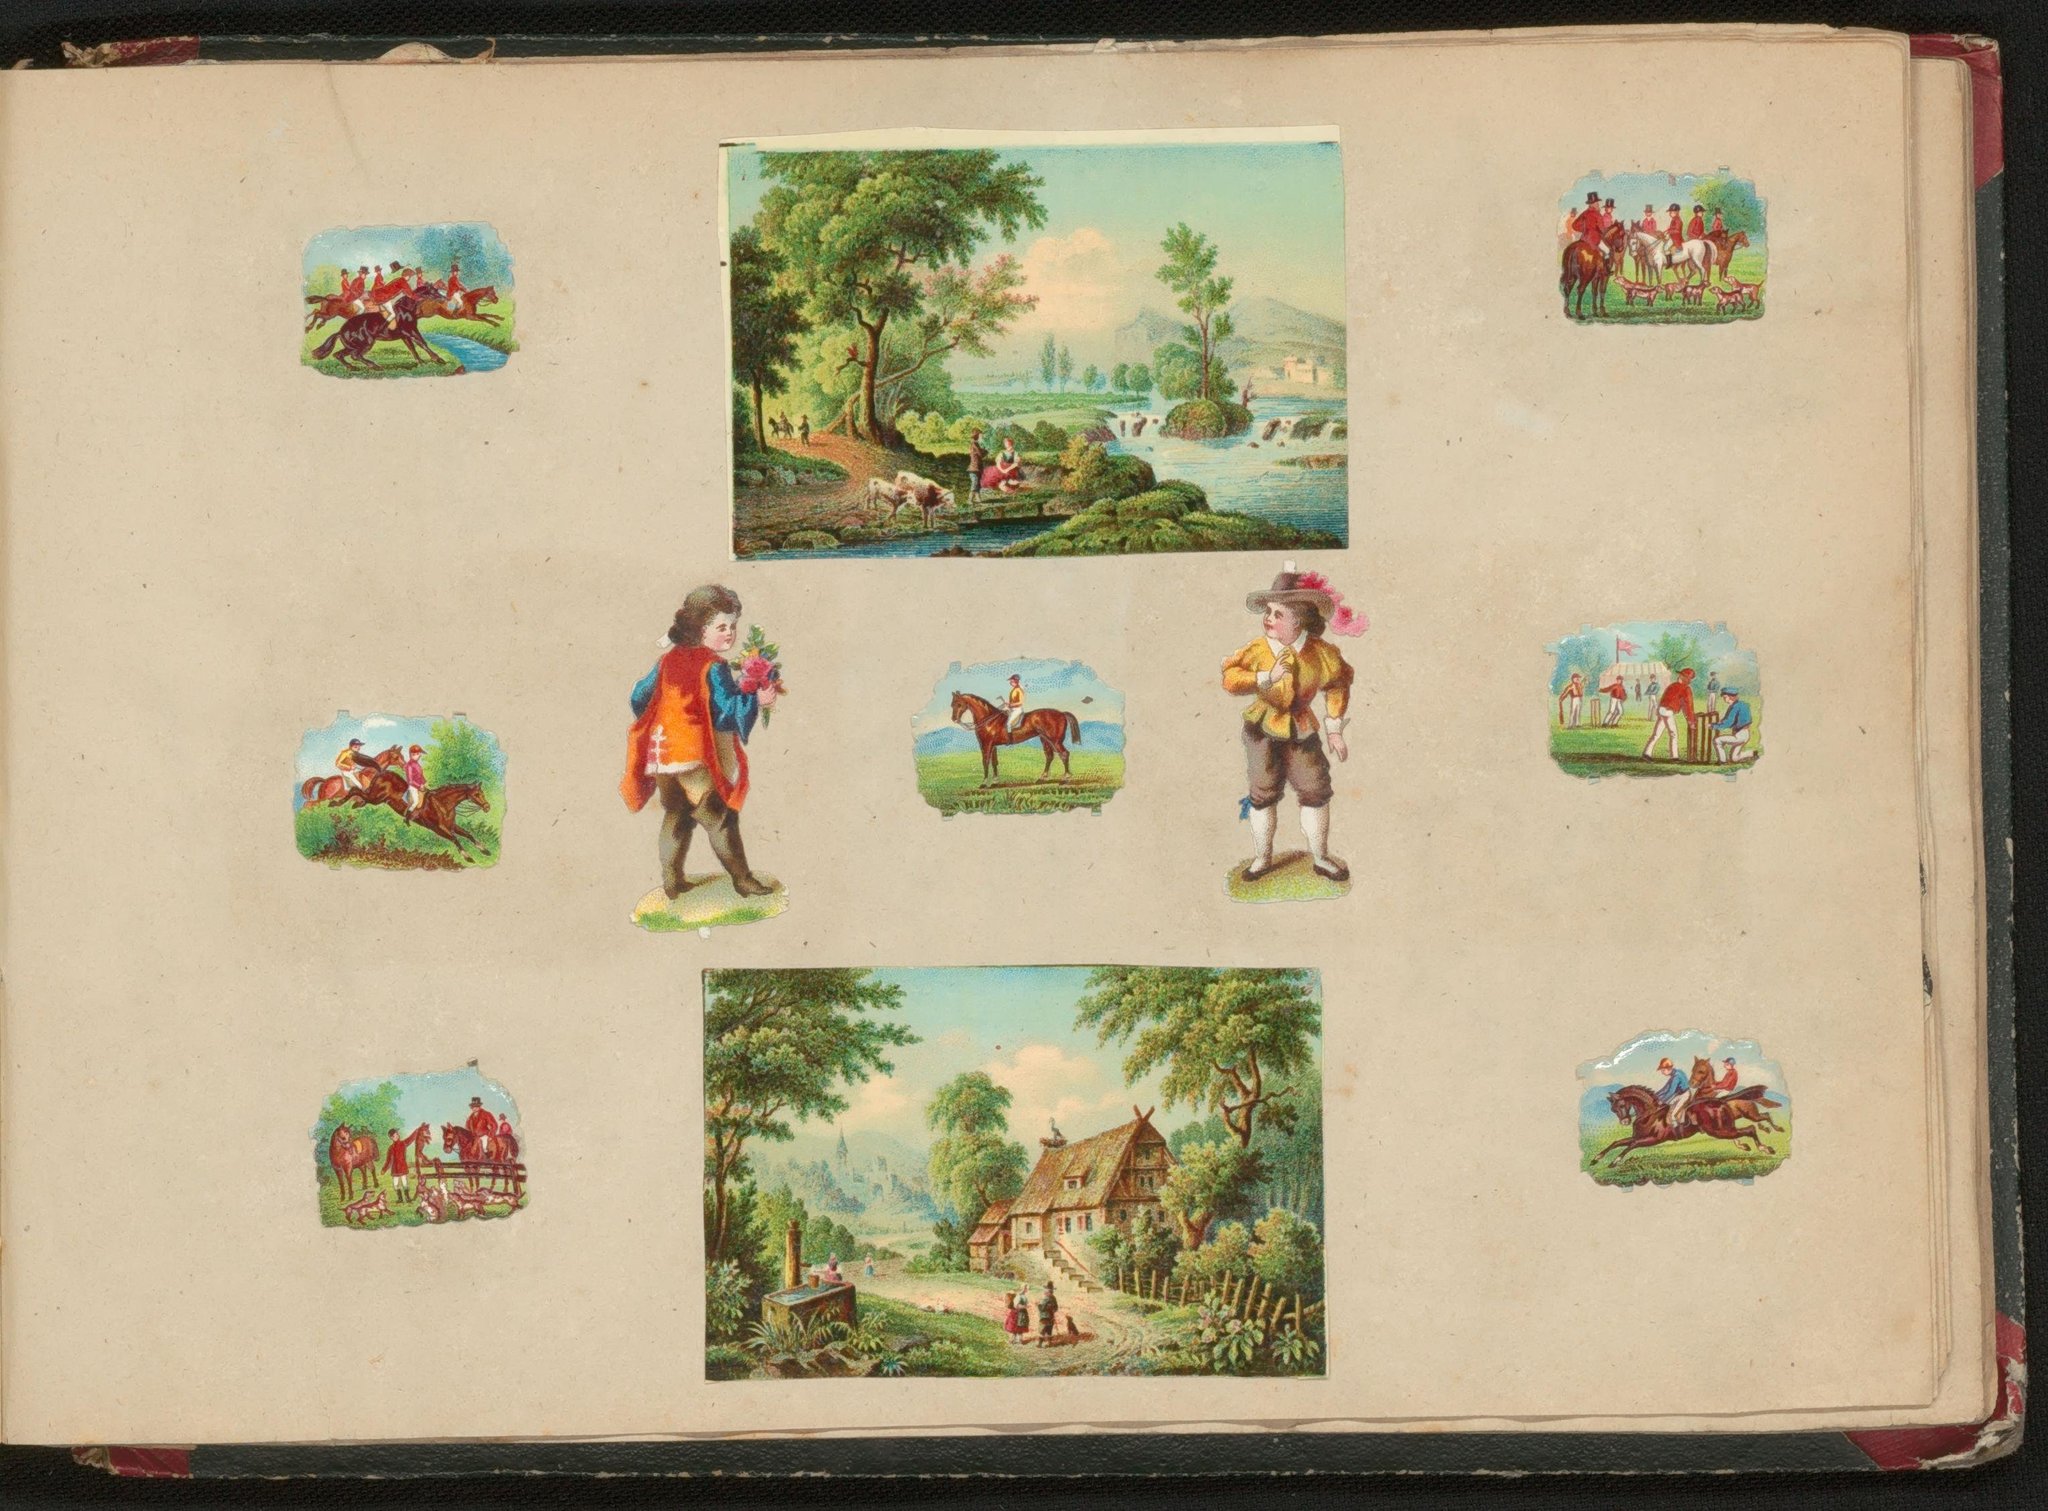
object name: album leaf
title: Albumblad met 11 plakplaatjes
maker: Anonymous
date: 1880-1910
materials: paper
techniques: chromolithography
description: Albumblad met 11 plakplaatjes. Onderdeel van het plakboek met 38 bladen gevuld met plakplaatjes, poesieplaatjes en uitgeknipte en ingeplakte fragmenten van prenten. Onderwerpsrubrieken binnen de Atlas Zeden en Gewoonten: Schoone kunsten, Varia.